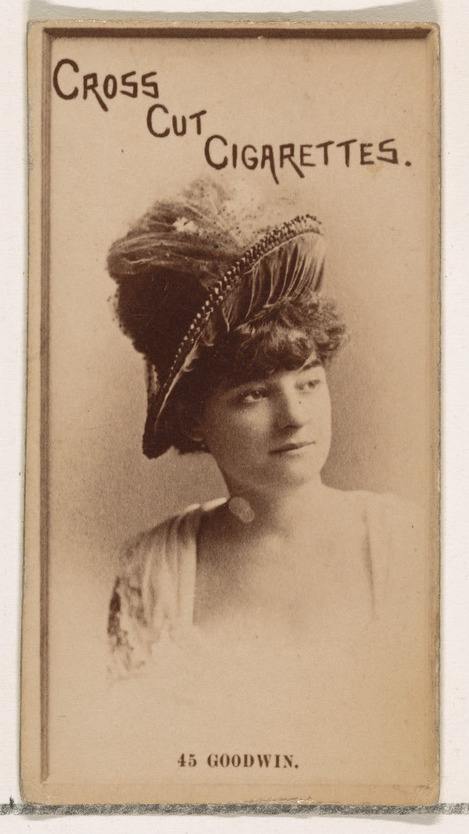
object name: print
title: Card Number 45, Myra Goodwin, from the Actors and Actresses series (N145-2) issued by Duke Sons & Co. to promote Cross Cut Cigarettes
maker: w. duke, sons & co.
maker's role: publisher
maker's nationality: american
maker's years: 1870-1920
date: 1880-1889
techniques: albumen silver print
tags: portraits,women,actresses